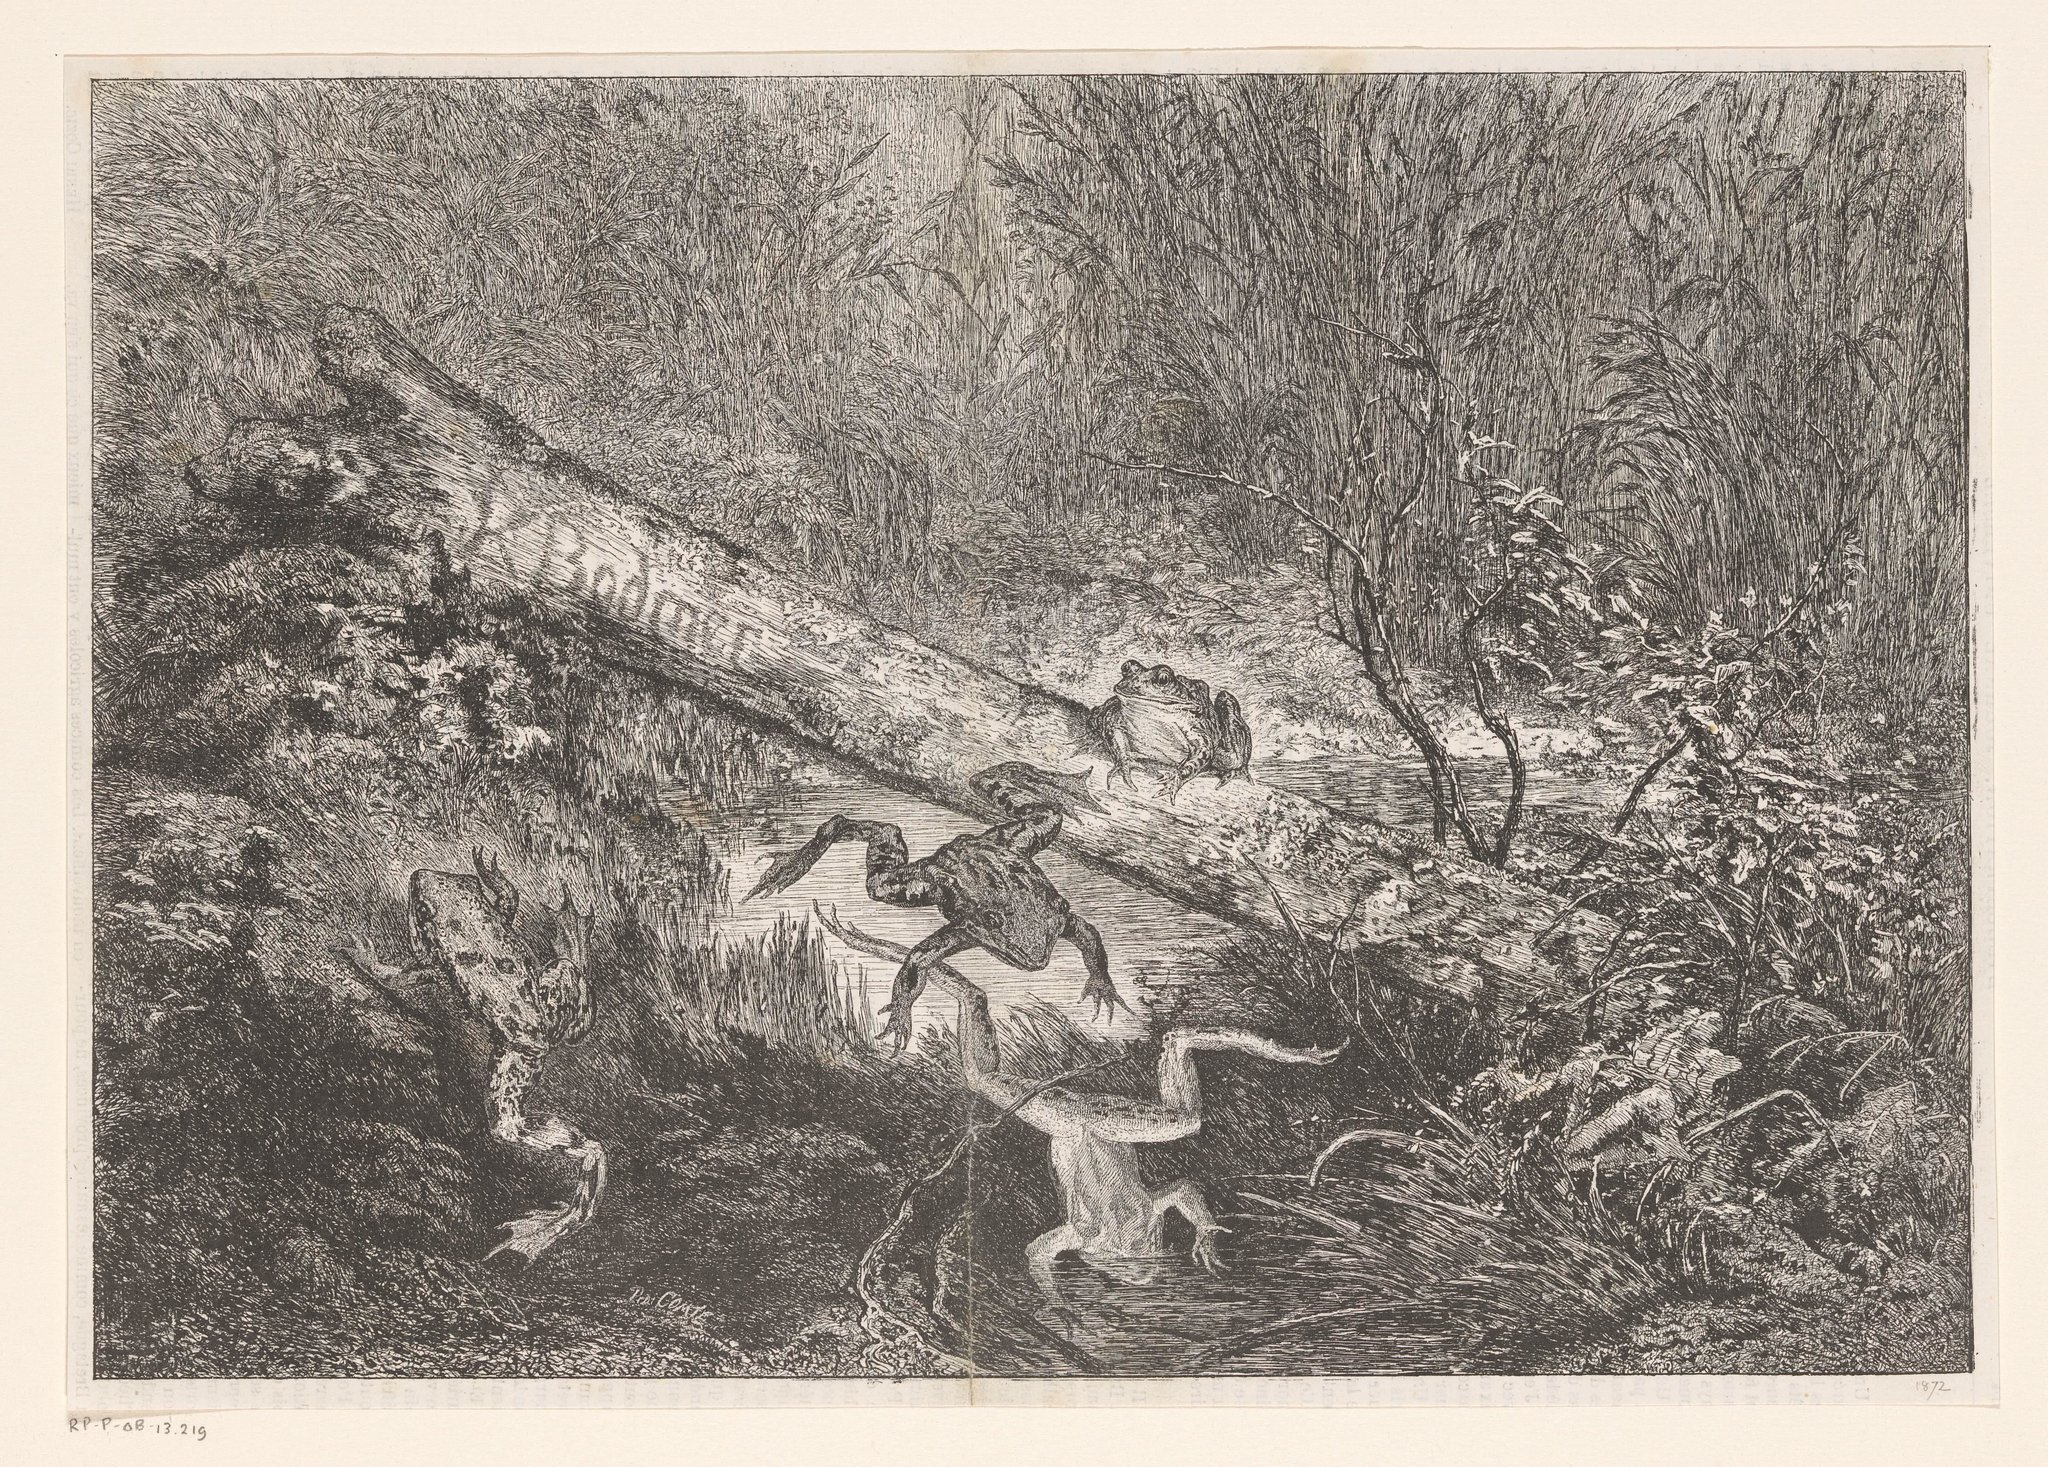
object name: print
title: Kikkers bij een vijver met een omgevallen boom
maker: karl bodmer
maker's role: draughtsman, painter, print maker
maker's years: 1809-1893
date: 1872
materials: paper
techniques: lithography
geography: barbizon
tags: tailless amphibians: frog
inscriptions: collector's mark: Lugt 2228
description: Prent waarschijnlijk afkomstig uit: L'illustration 60 (1872).